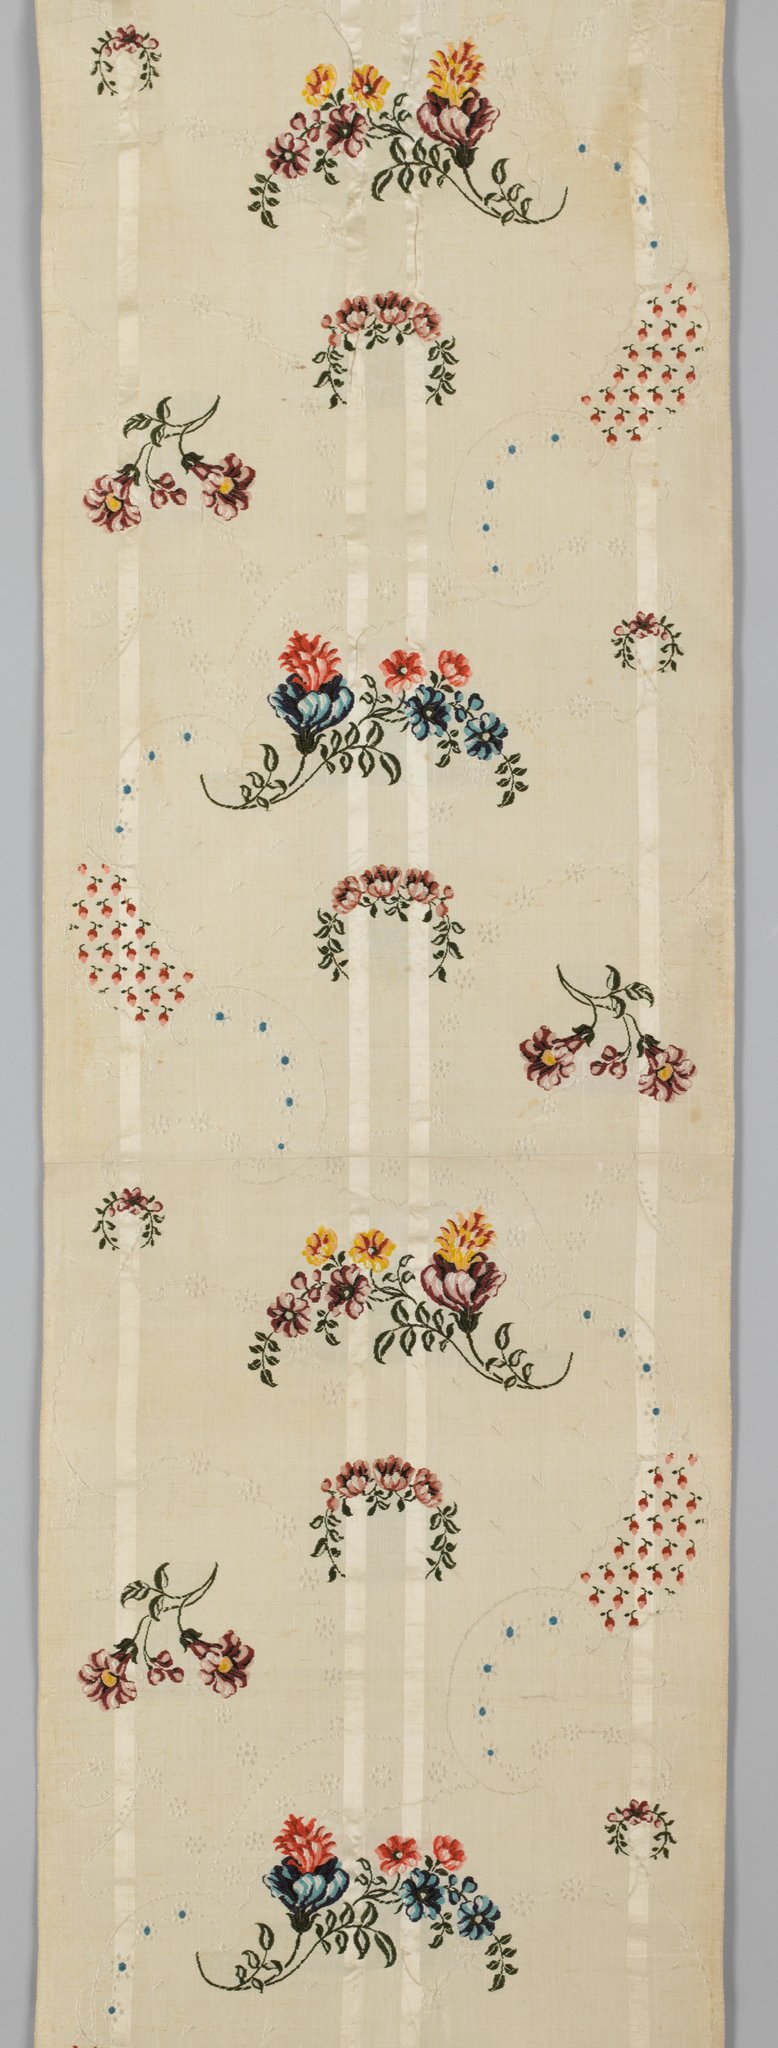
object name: panel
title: Dress panels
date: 1775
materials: silk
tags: flowers